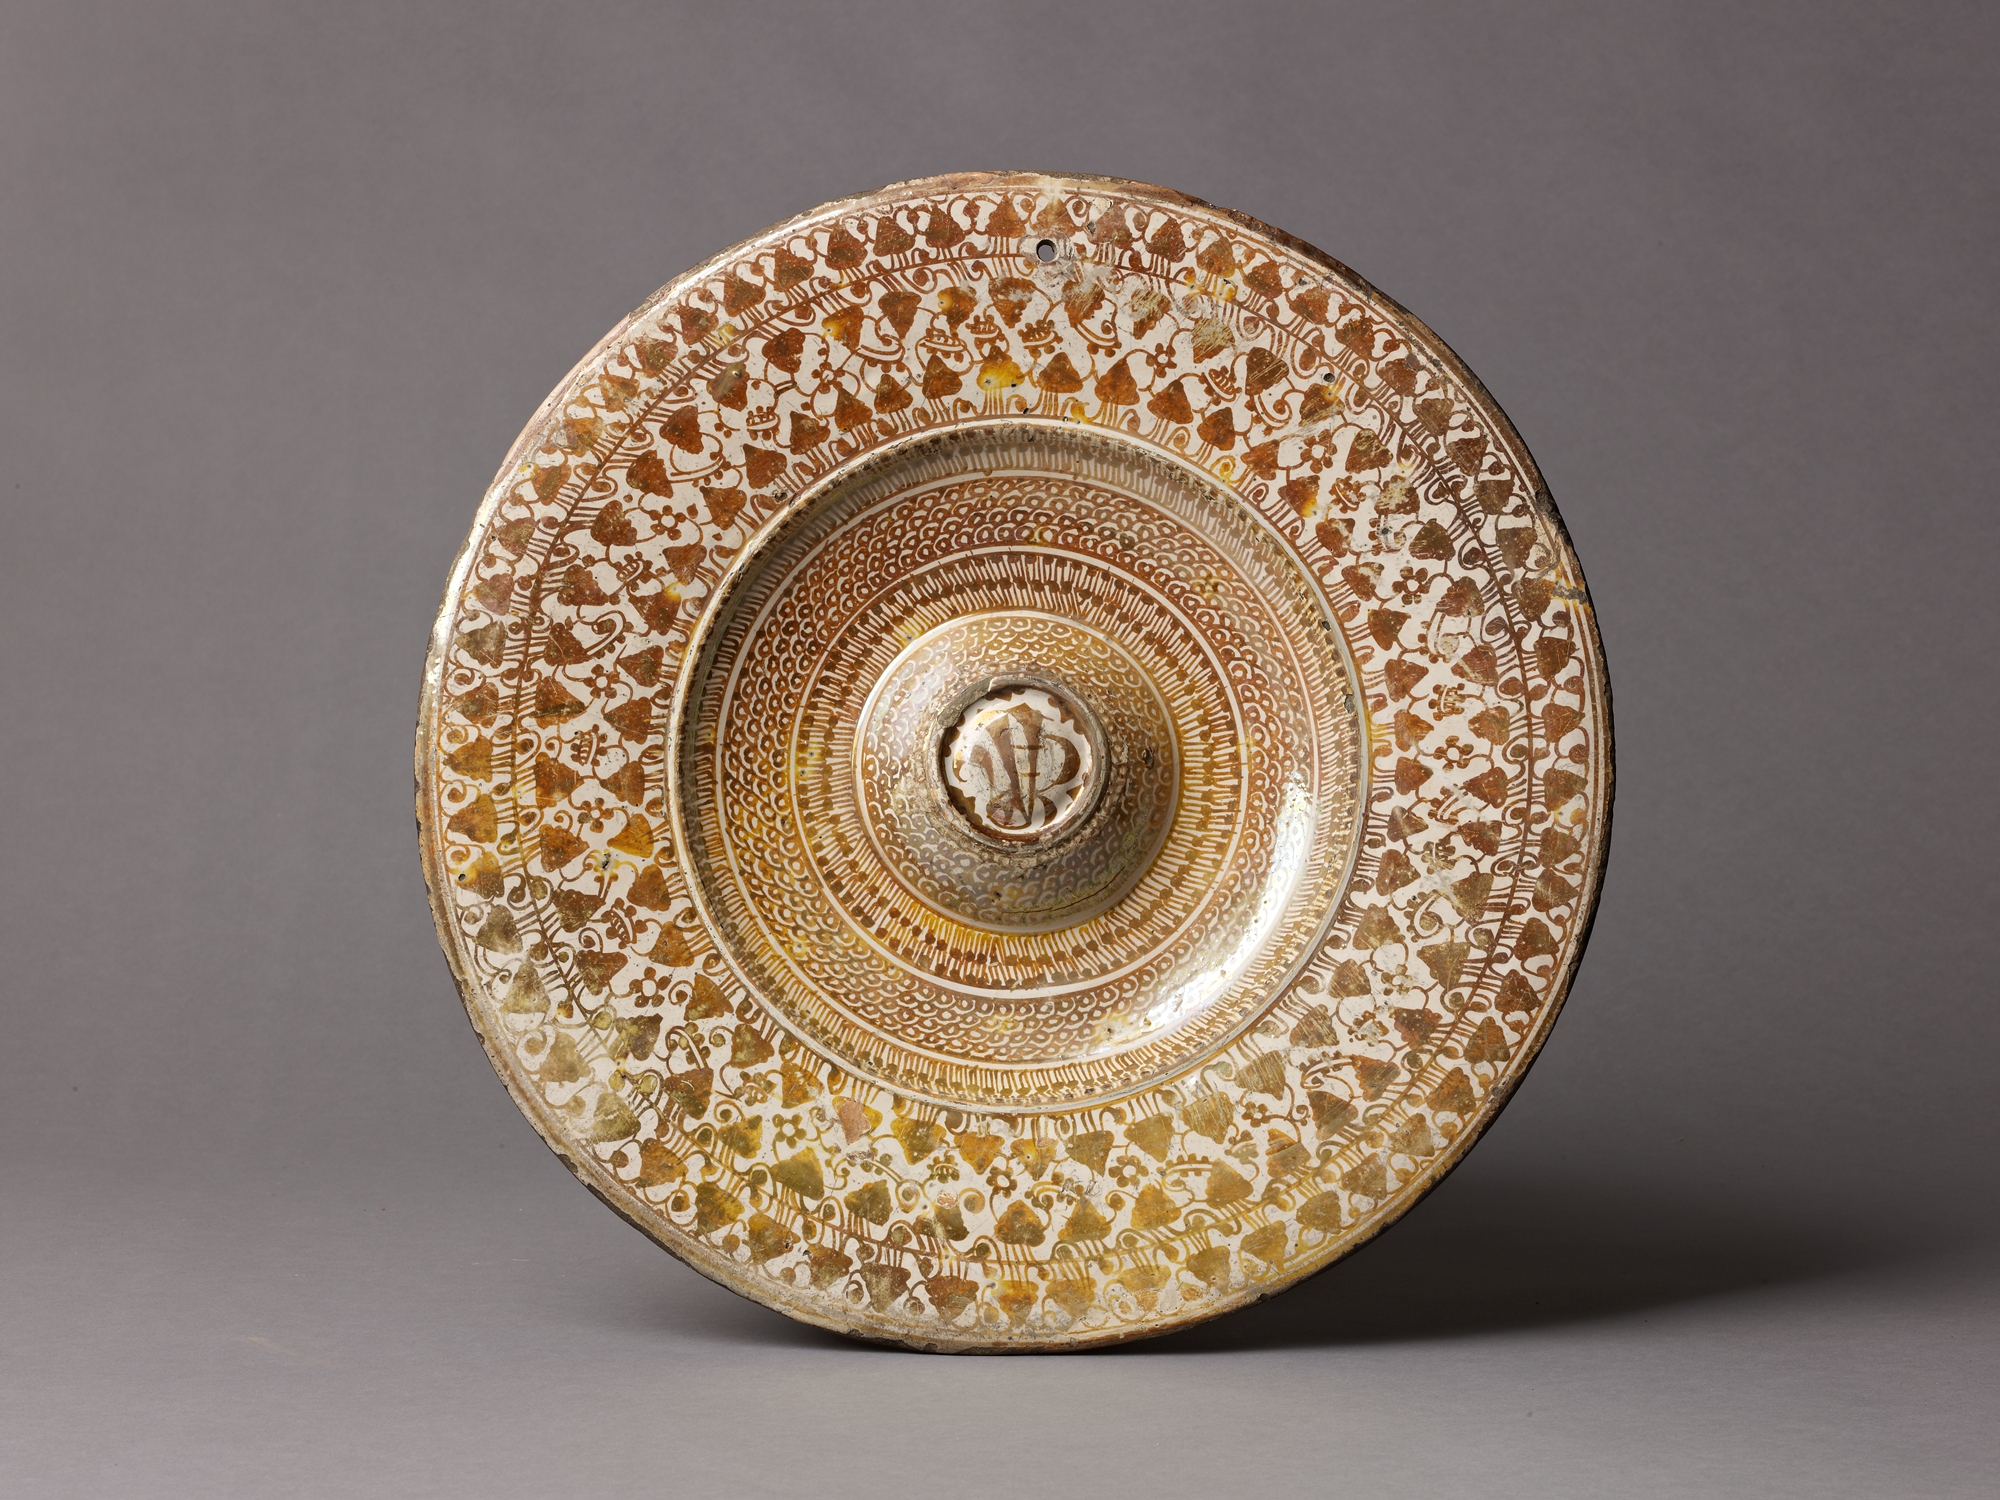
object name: dish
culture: spanish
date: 1451-1500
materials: earthenware, glaze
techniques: luster painting